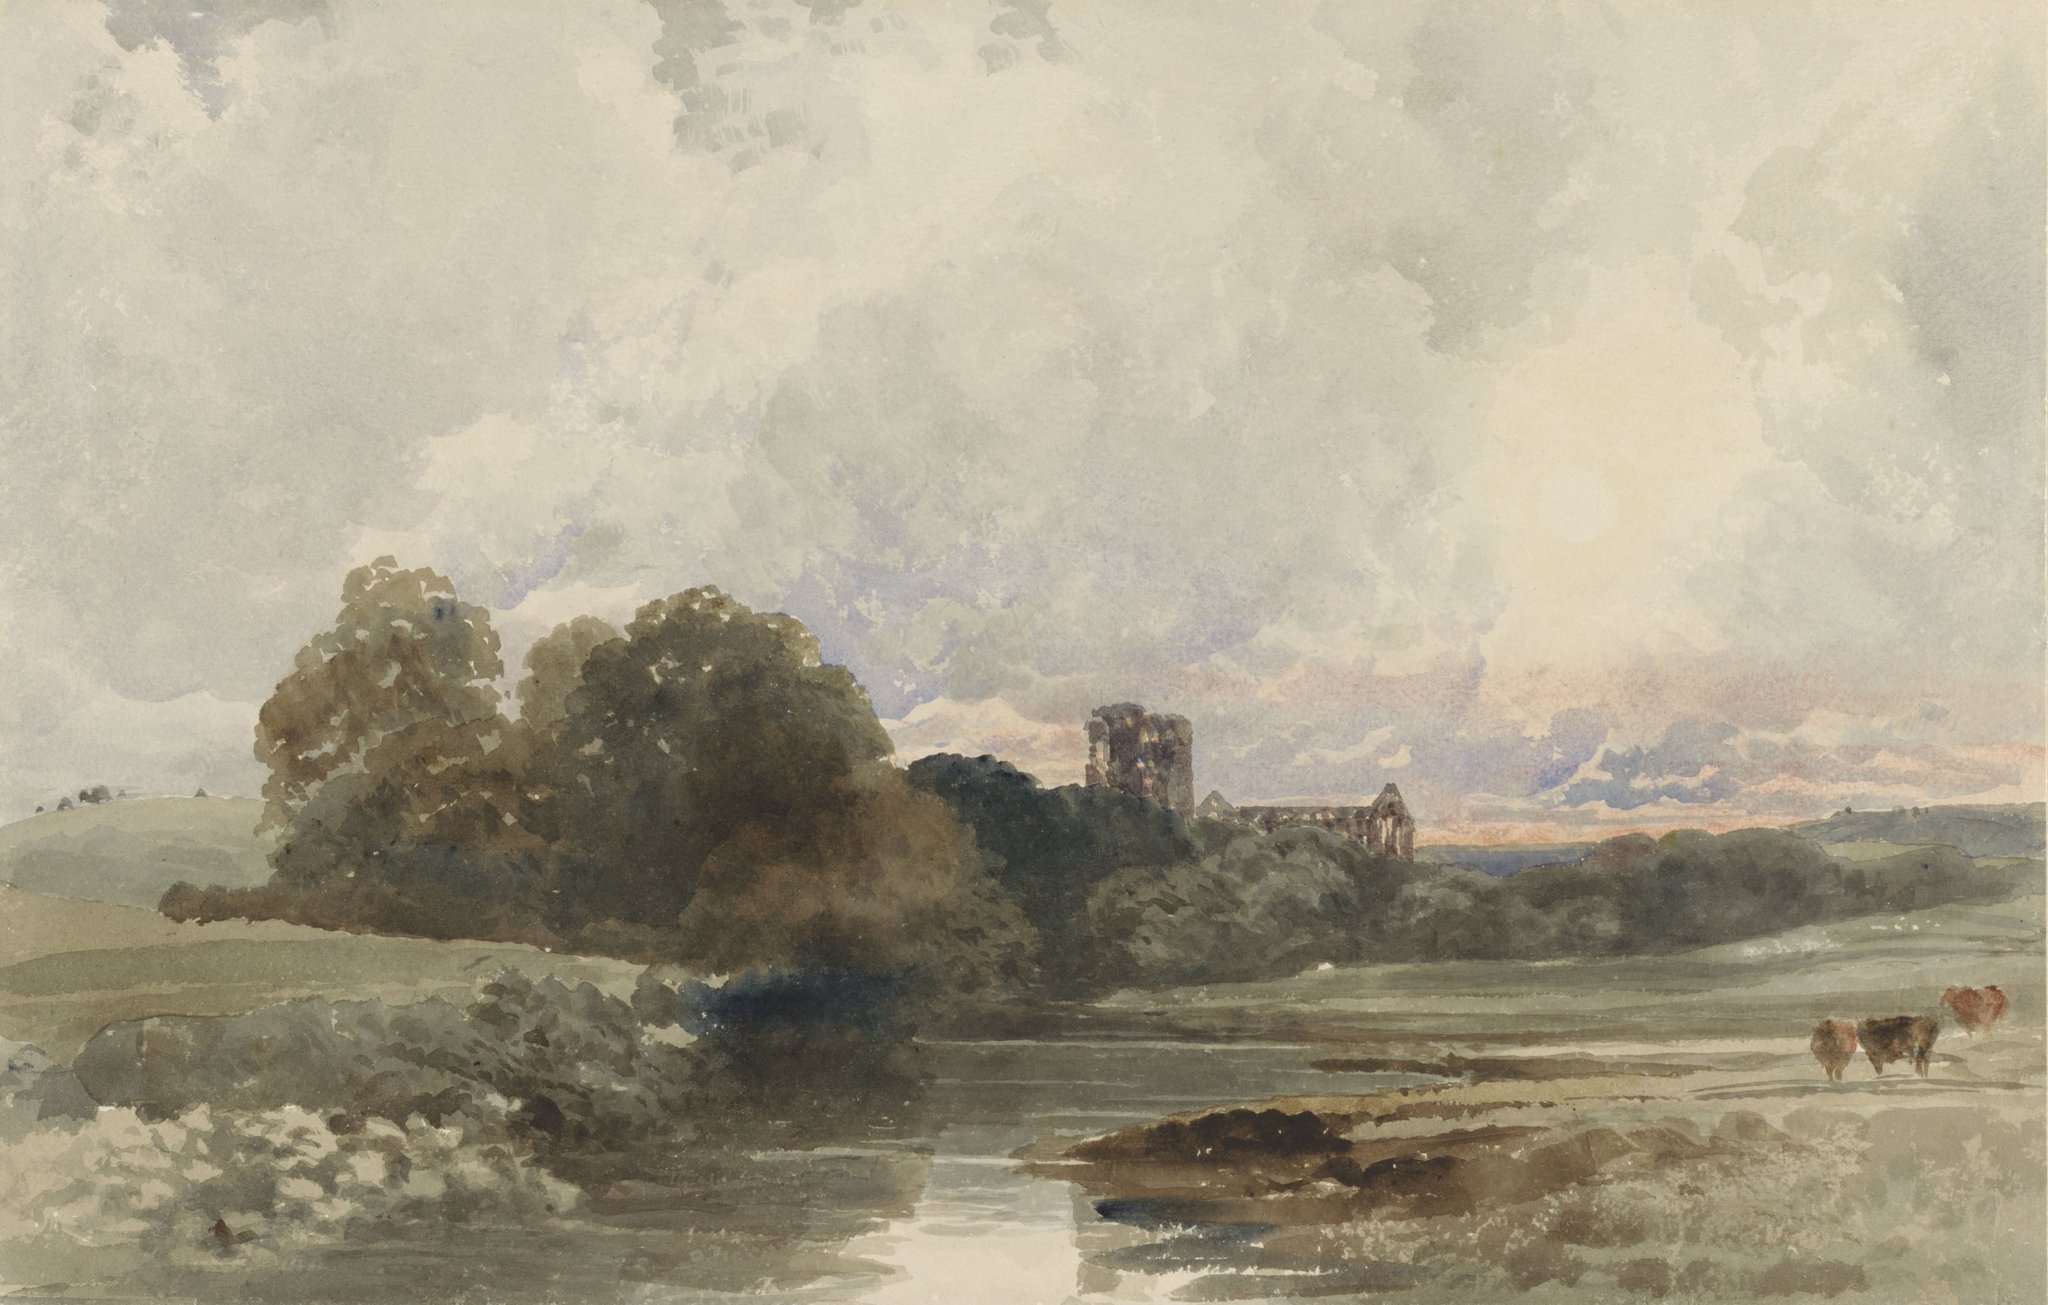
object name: drawing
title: Avondlandschap met de ruïne van Kirkstall Abbey, Yorkshire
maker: peter de wint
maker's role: draughtsman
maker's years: 1784-1849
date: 1794-1849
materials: paper, watercolor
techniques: brush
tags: abbey, monastery, convent ~ roman catholic church, landscape with ruins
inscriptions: : ‘P. de Wint. Evening’